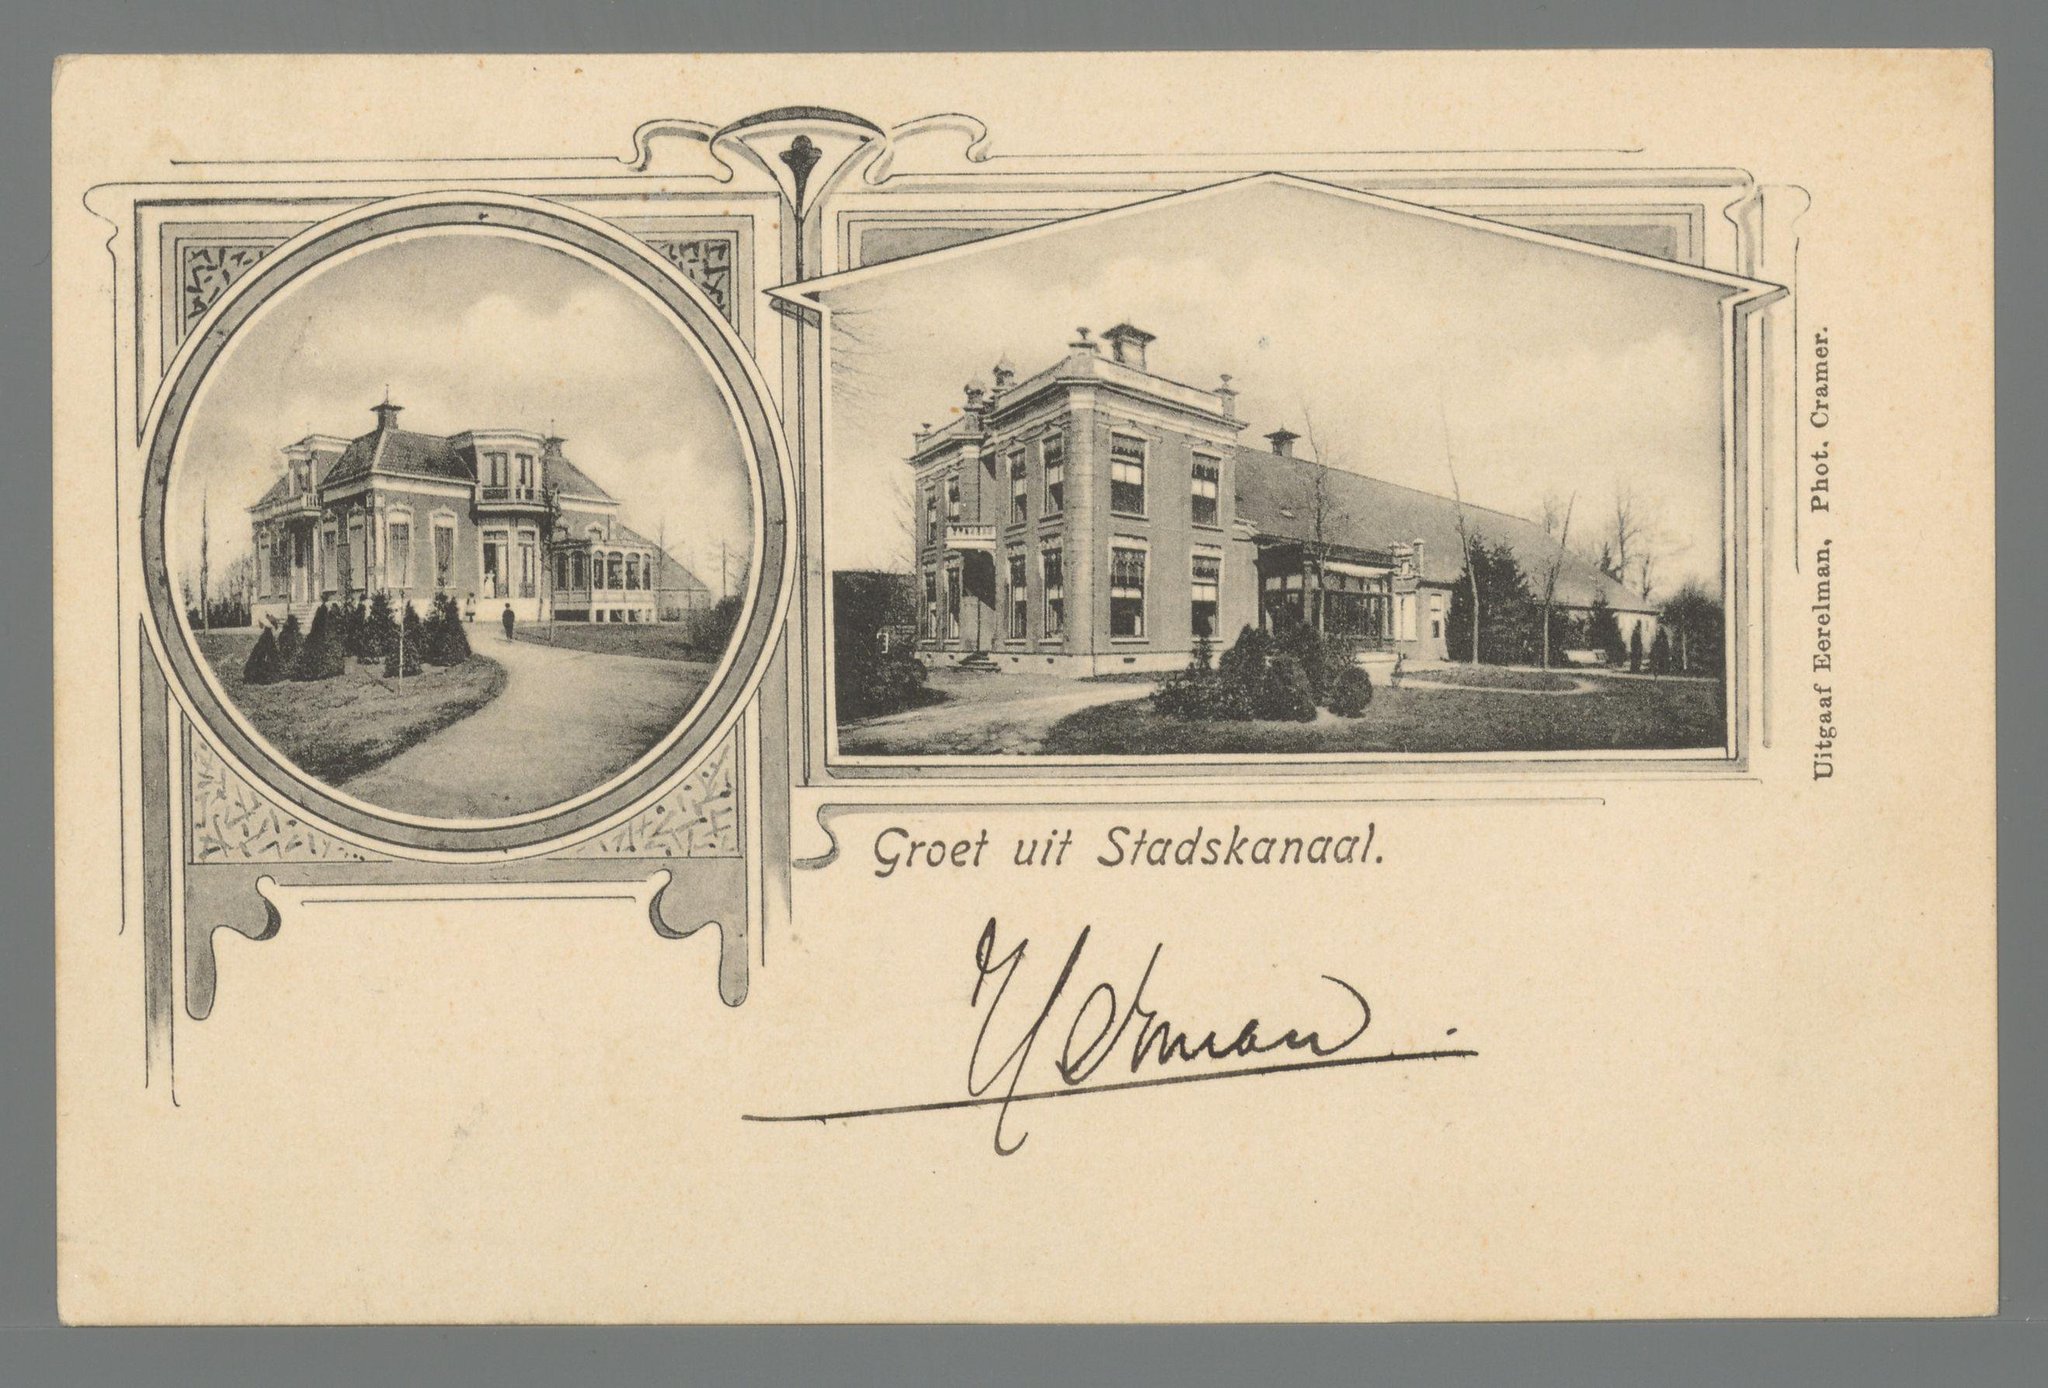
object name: ansichtkaart, prentbriefkaart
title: Groet uit Stadskanaal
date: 1892-1900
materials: cardboard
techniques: photograph, writing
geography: stadskanaal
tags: city-view, and landscape with man-made constructions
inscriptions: postage stamp